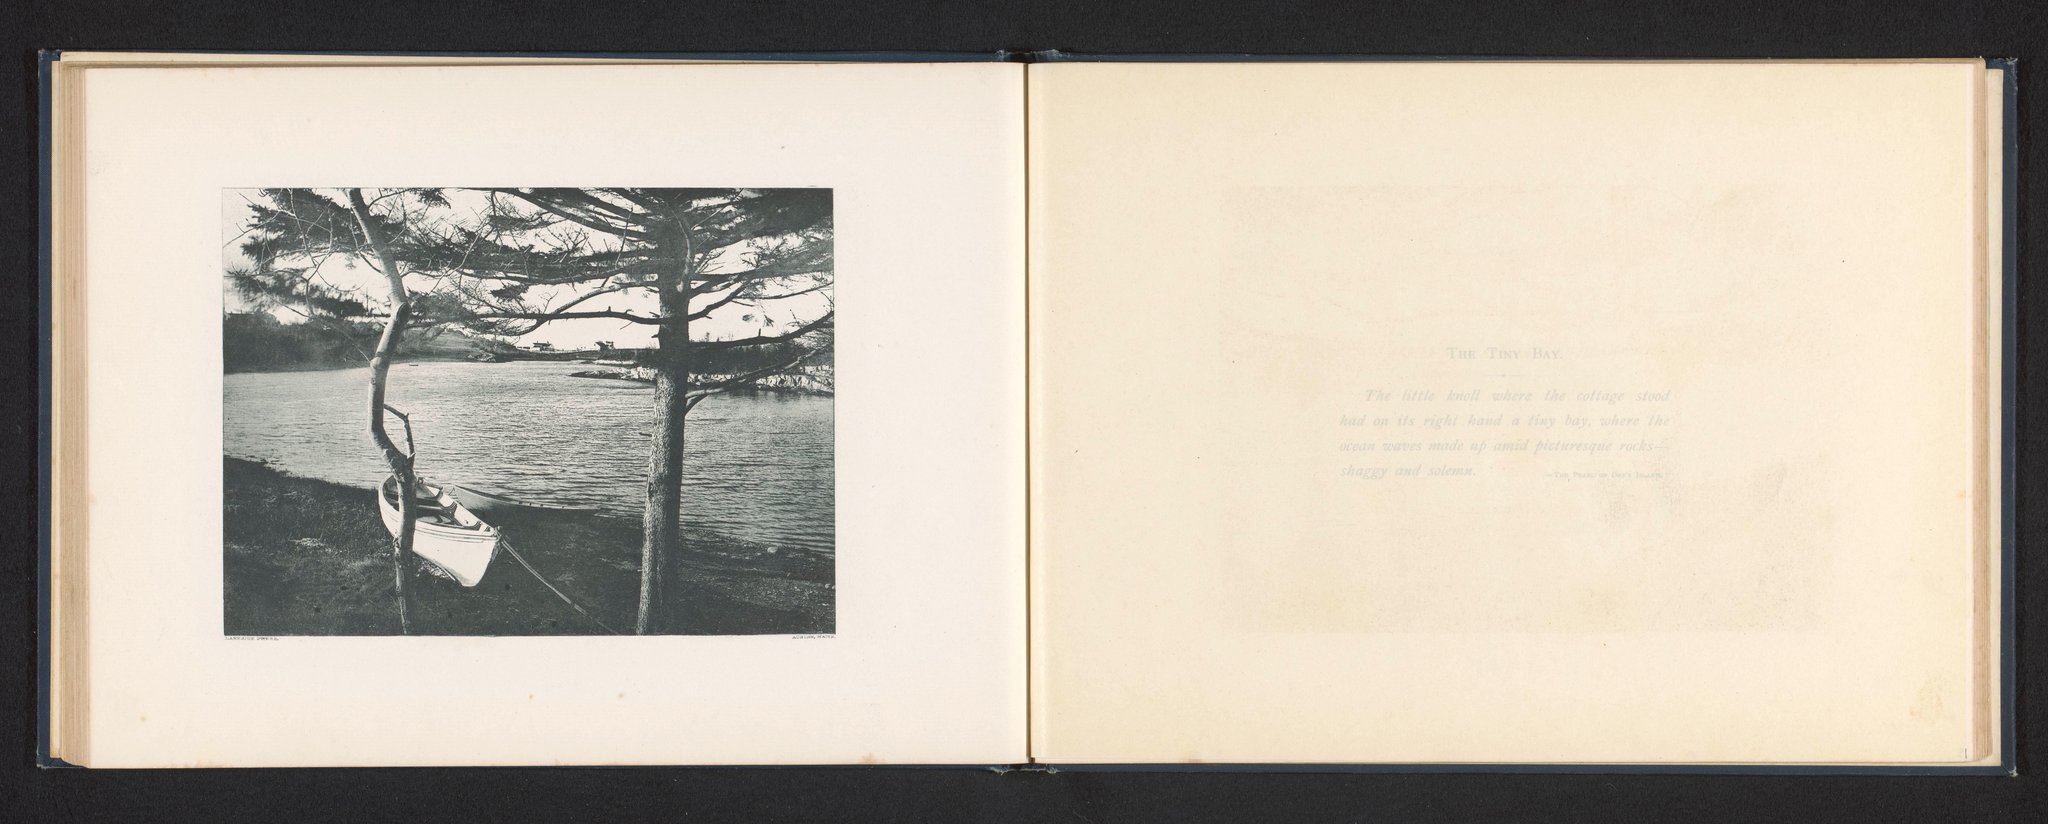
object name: page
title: Gezicht op een baai met een boot op de kant in vermoedelijk Maine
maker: Anonymous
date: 1880-1890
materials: paper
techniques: photoaquatint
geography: maine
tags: gulf, bay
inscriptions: inscription: ‘The Tiny Bay. (...)’